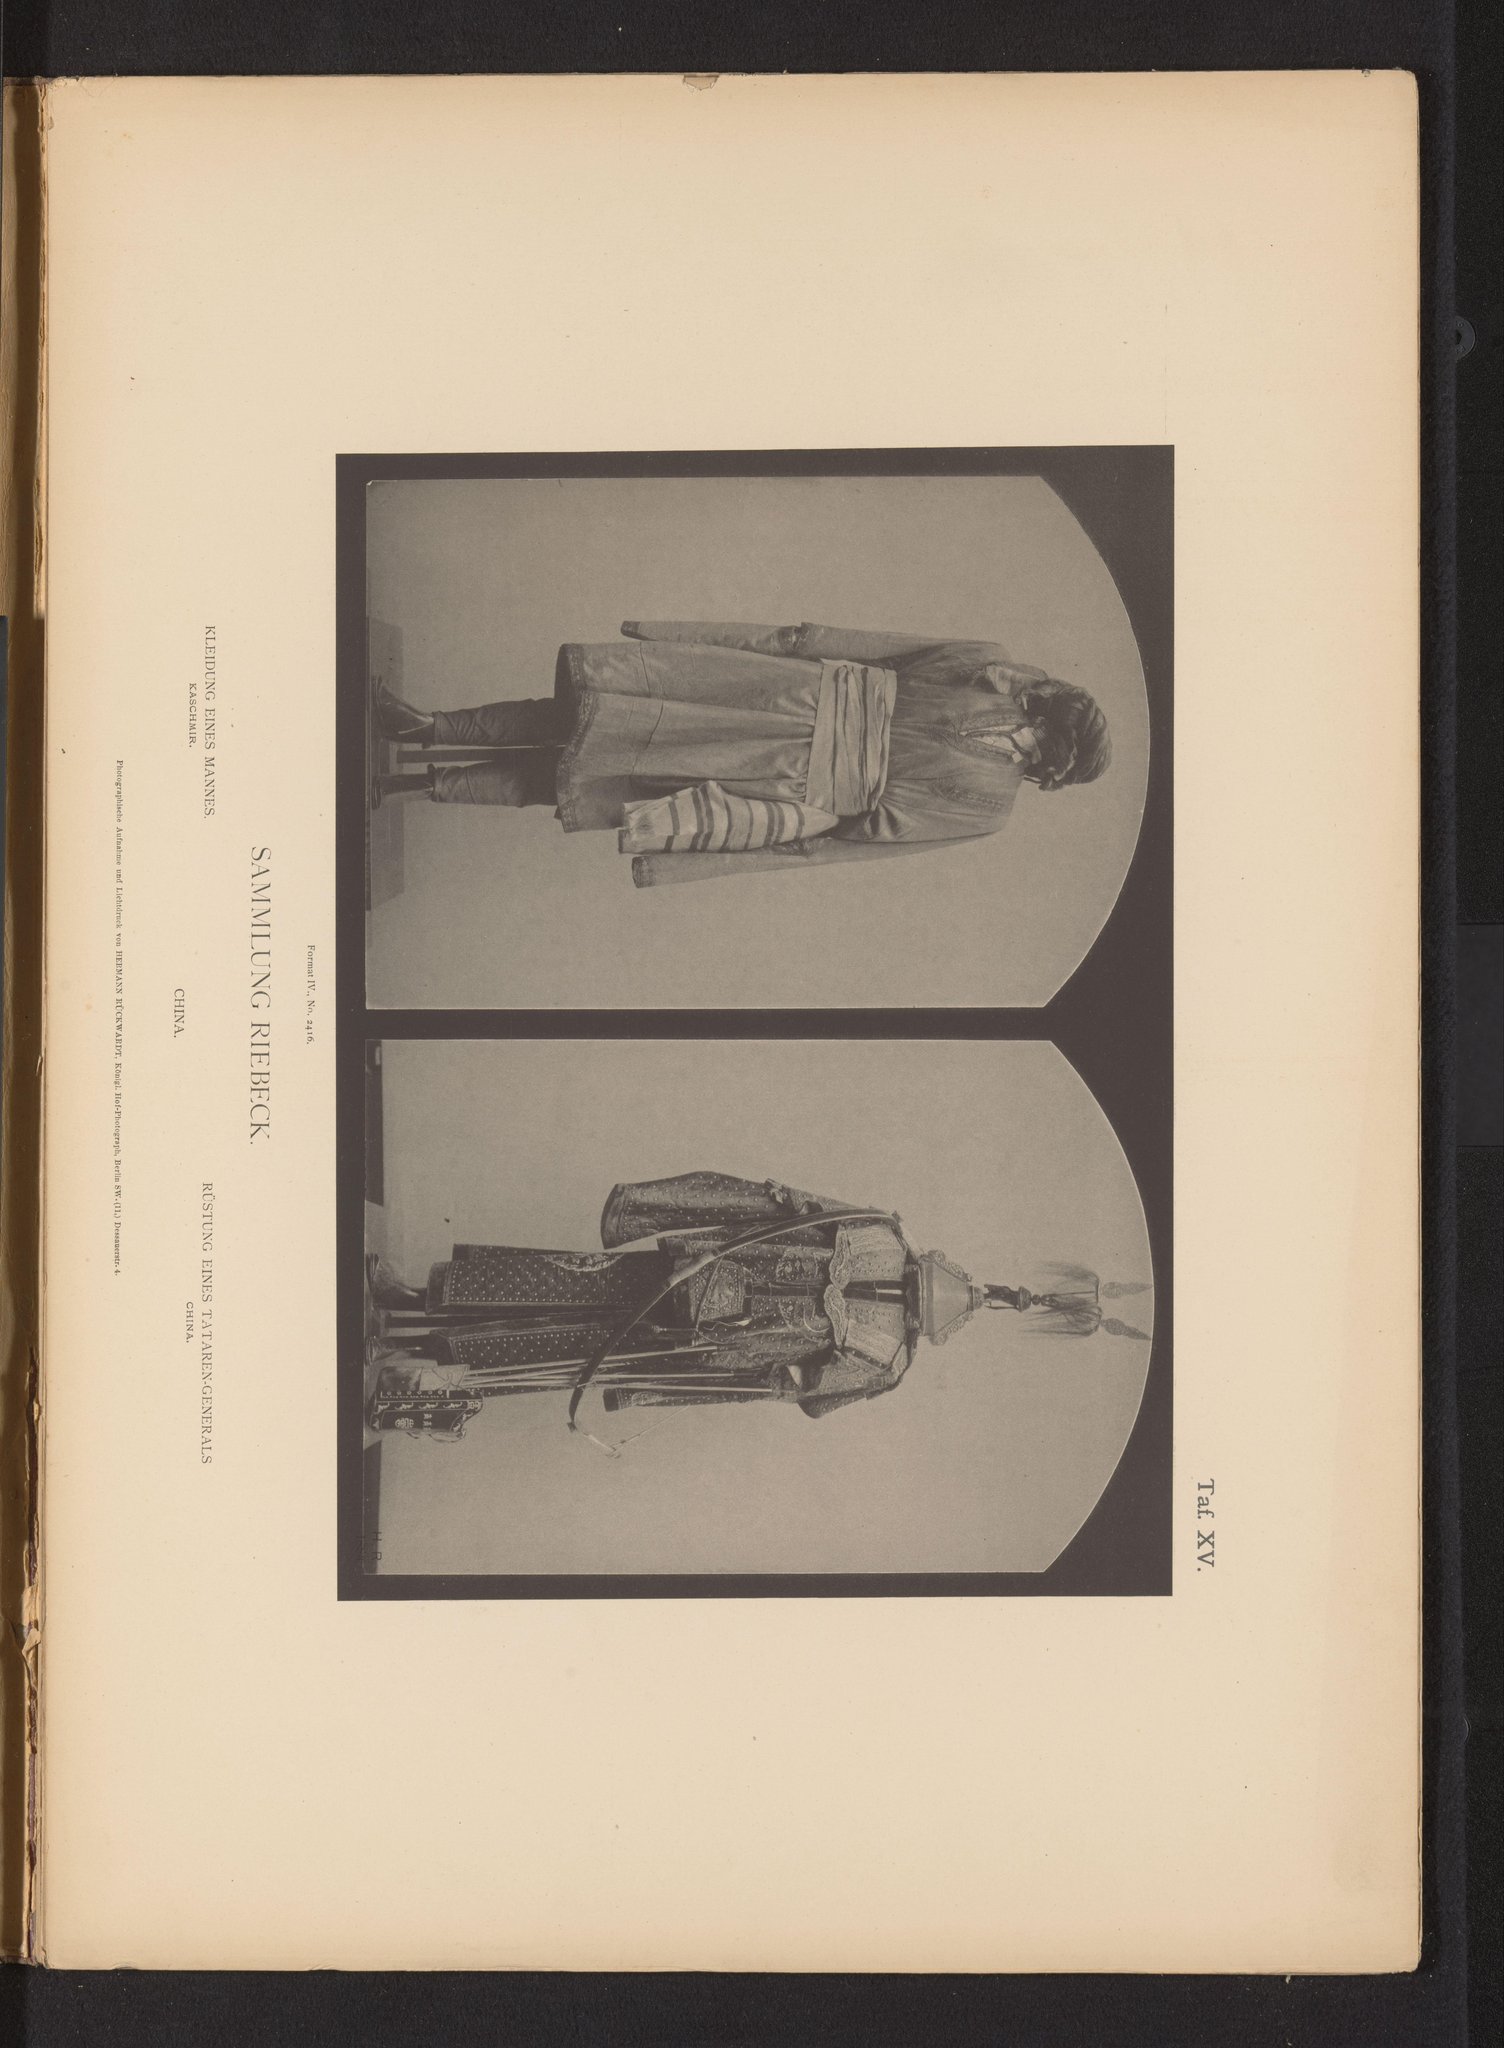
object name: photomechanical print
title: Rüstung eines Tartaren-Generals. China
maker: hermann rückwardt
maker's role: fotograaf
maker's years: 1845-1919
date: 1884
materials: paper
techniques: photograph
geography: berlin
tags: permanent exhibition, museum, folk costume, regional costume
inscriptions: number: ‘Taf. XV.’, number: ‘Format IV., No. 2416.’, address: ‘Photographische Aufnahme und Lichtdruck von HERMANN RÜCKWARDT, Königl. Hof-Photograph, Berlin SW.(11,) Dessauerstr. 4.’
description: Deze prent maakt deel uit van een omslag met 21 prenten en 1 tekstblad.